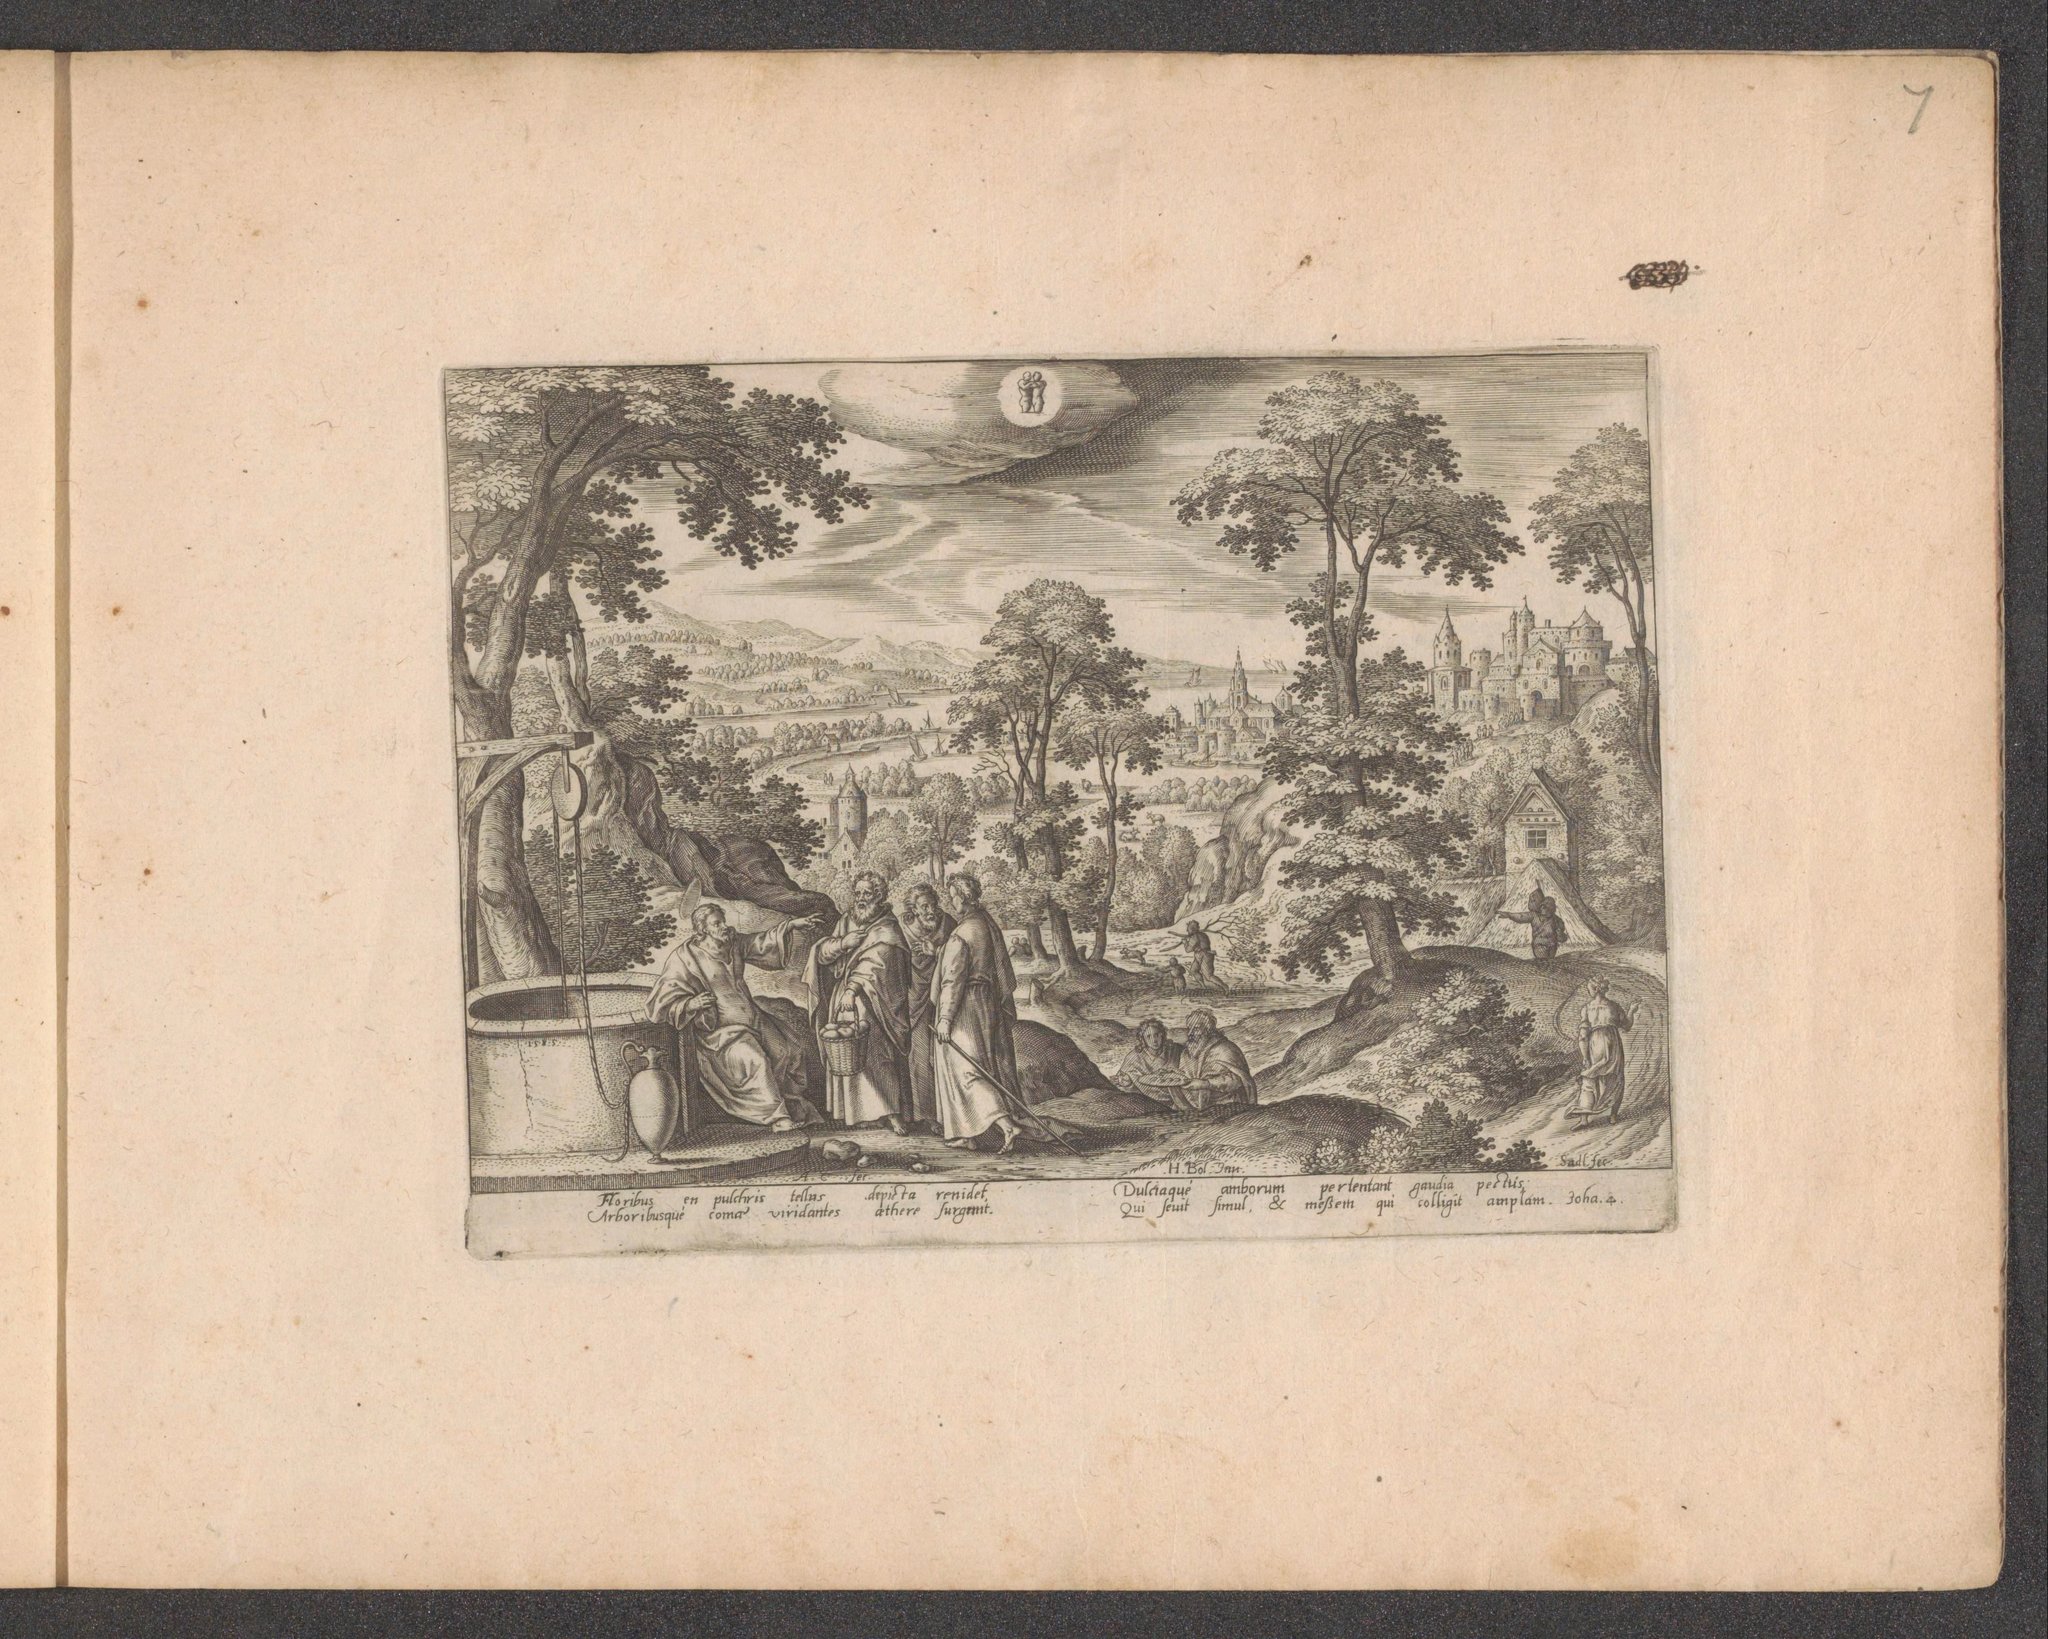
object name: album leaf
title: Emblemata Evangelica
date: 1585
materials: paper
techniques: engraving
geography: antwerp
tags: landscape symbolizing may, christ's disciples returning from sychar, may ~ other concepts (+ with zodiacal signs), the woman of samaria (john 4:4-42), gemini (zodiacal sign of may)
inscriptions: date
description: Middenboven het teken van de dierenriem Tweeling. Op de voorgrond Christus bij de bron van Jakob. Zijn leerlingen bevragen hem over de Samaritaanse vrouw, die juist vertrokken is. Rivierlandschap op de achtergrond. Onder de voorstelling vier regels Latijn in twee kolommen (Joh. 4). De prent maakt deel uit van een album.